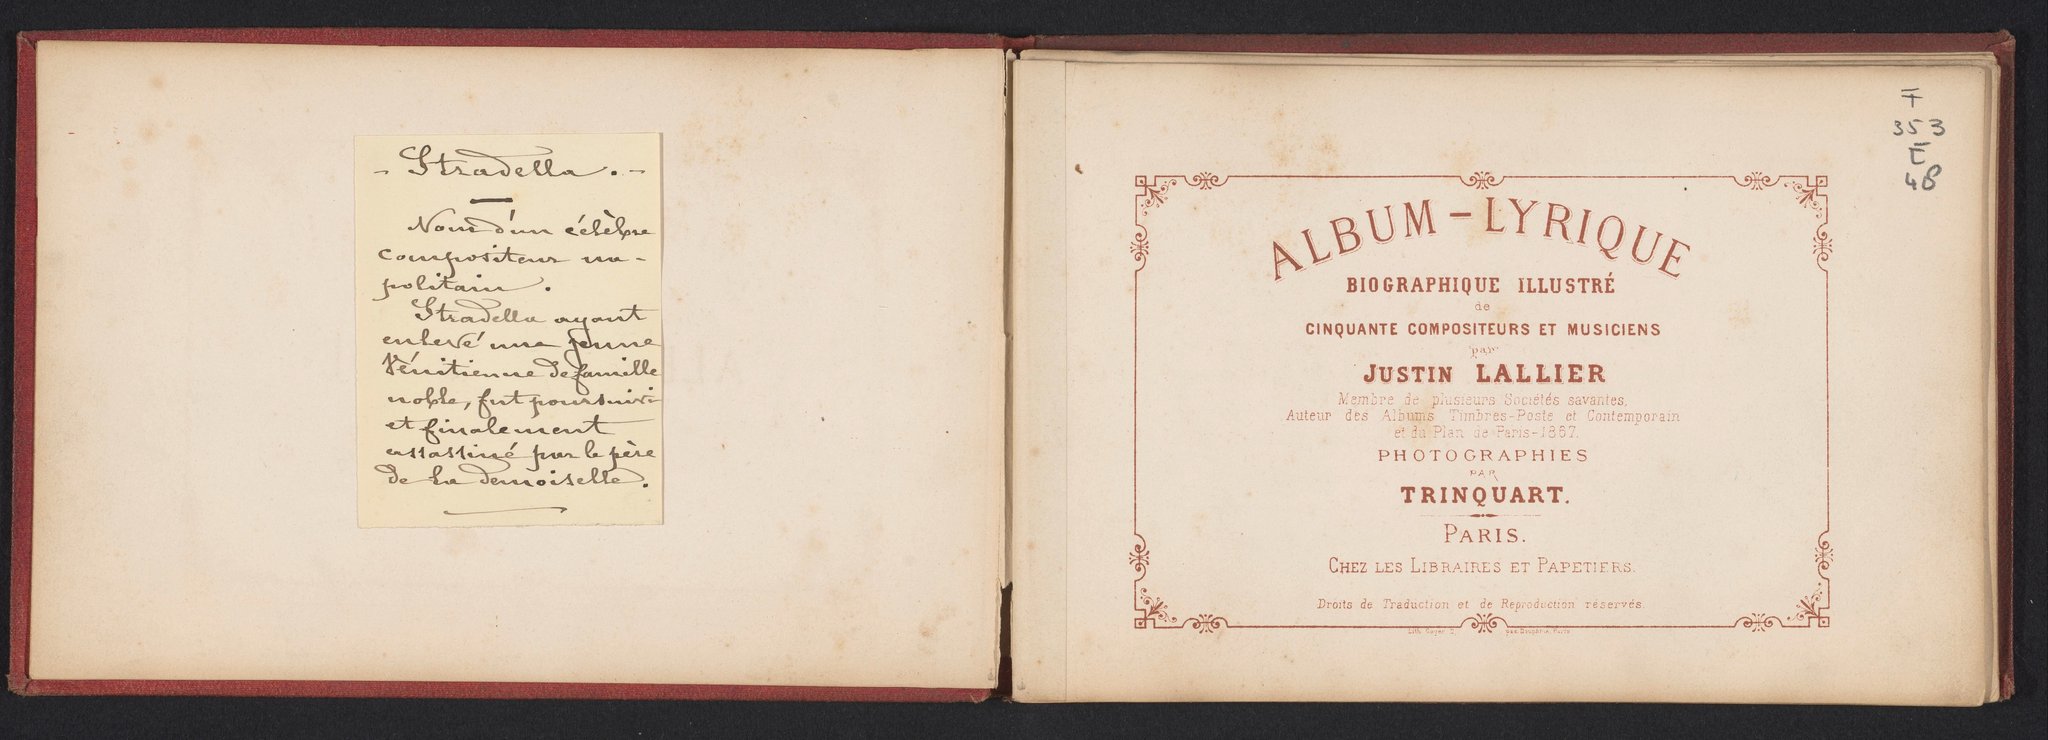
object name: book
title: Album-lyrique, biographique, illustré de cinquante compositeurs et musiciens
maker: justin lallier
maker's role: verzamelaar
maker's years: 1823-1873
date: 1868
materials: cardboard, linen, paper, photographic support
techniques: albumen print, printing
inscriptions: name: ‘ex libris SFJ’, name: ‘Aug. Leuralle.’